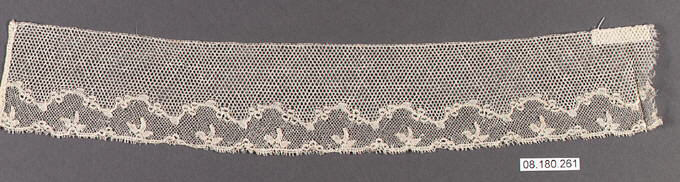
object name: fragment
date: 1701-1800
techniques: lace